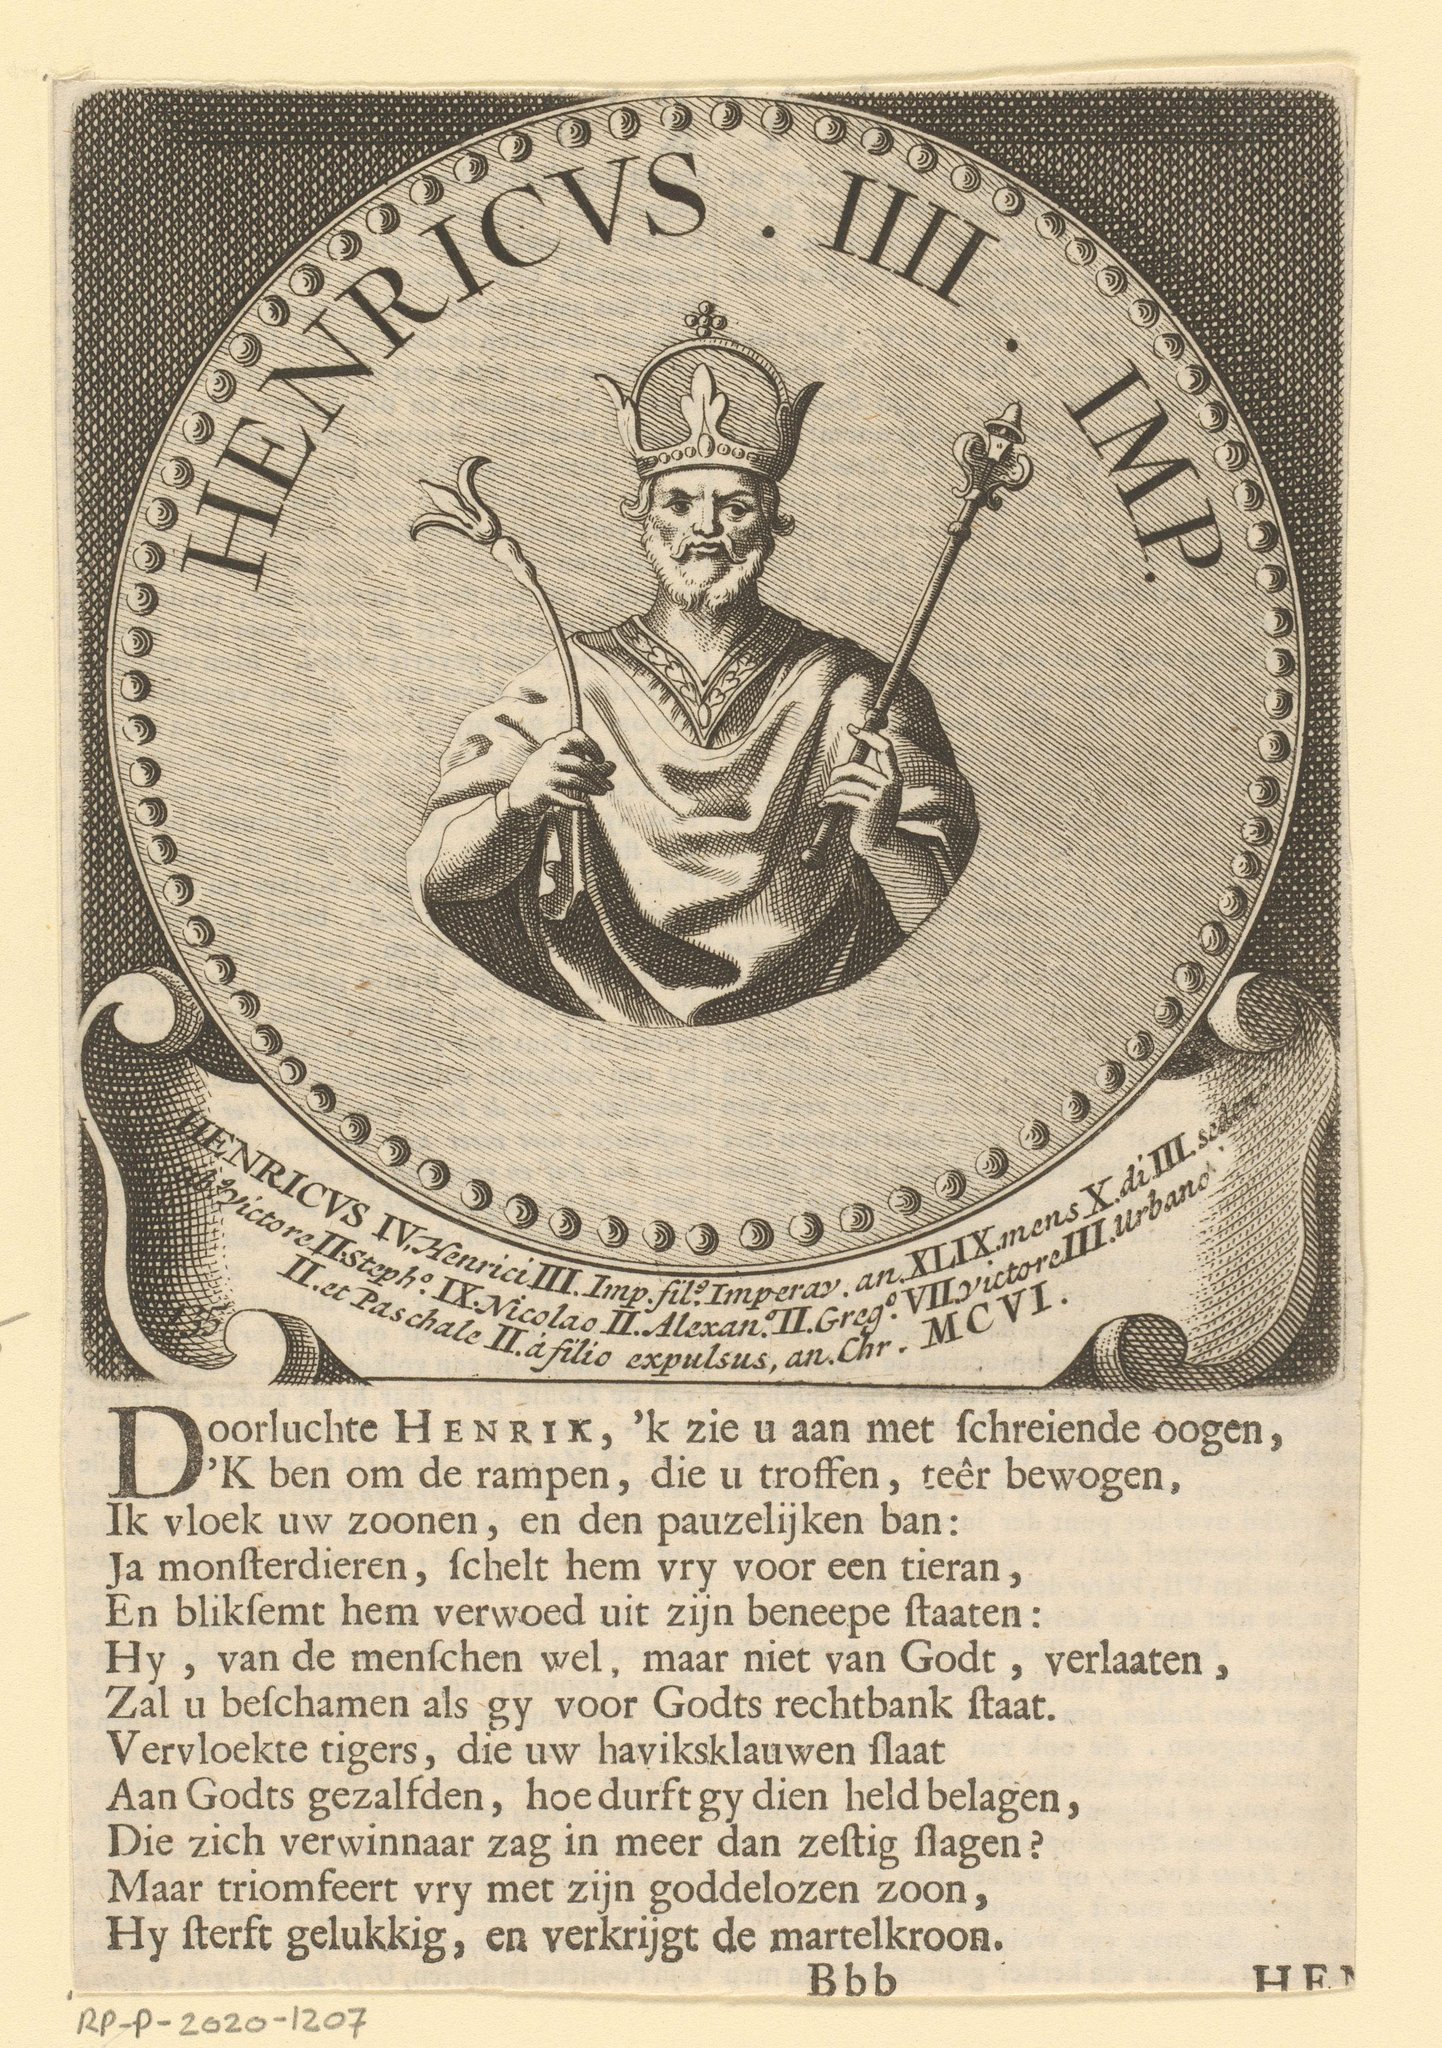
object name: book illustration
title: Henricus. IIII. imp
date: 1697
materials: paper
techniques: engraving, etching, letterpress printing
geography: utrecht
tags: liège, crown (symbol of sovereignty), historical persons, hacking and thrusting weapons: sword, emperor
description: Prent uit: Bogaert, Abraham. De Roomsche monarchy, vertoont in de muntbeelden der westersche en oostersche keizeren (...). Utrecht: François Halma en Willem van de Water, 1697, p. 377. Eerste staat verschenen als grotere prent met 12 portretten, gedateerd 1695.